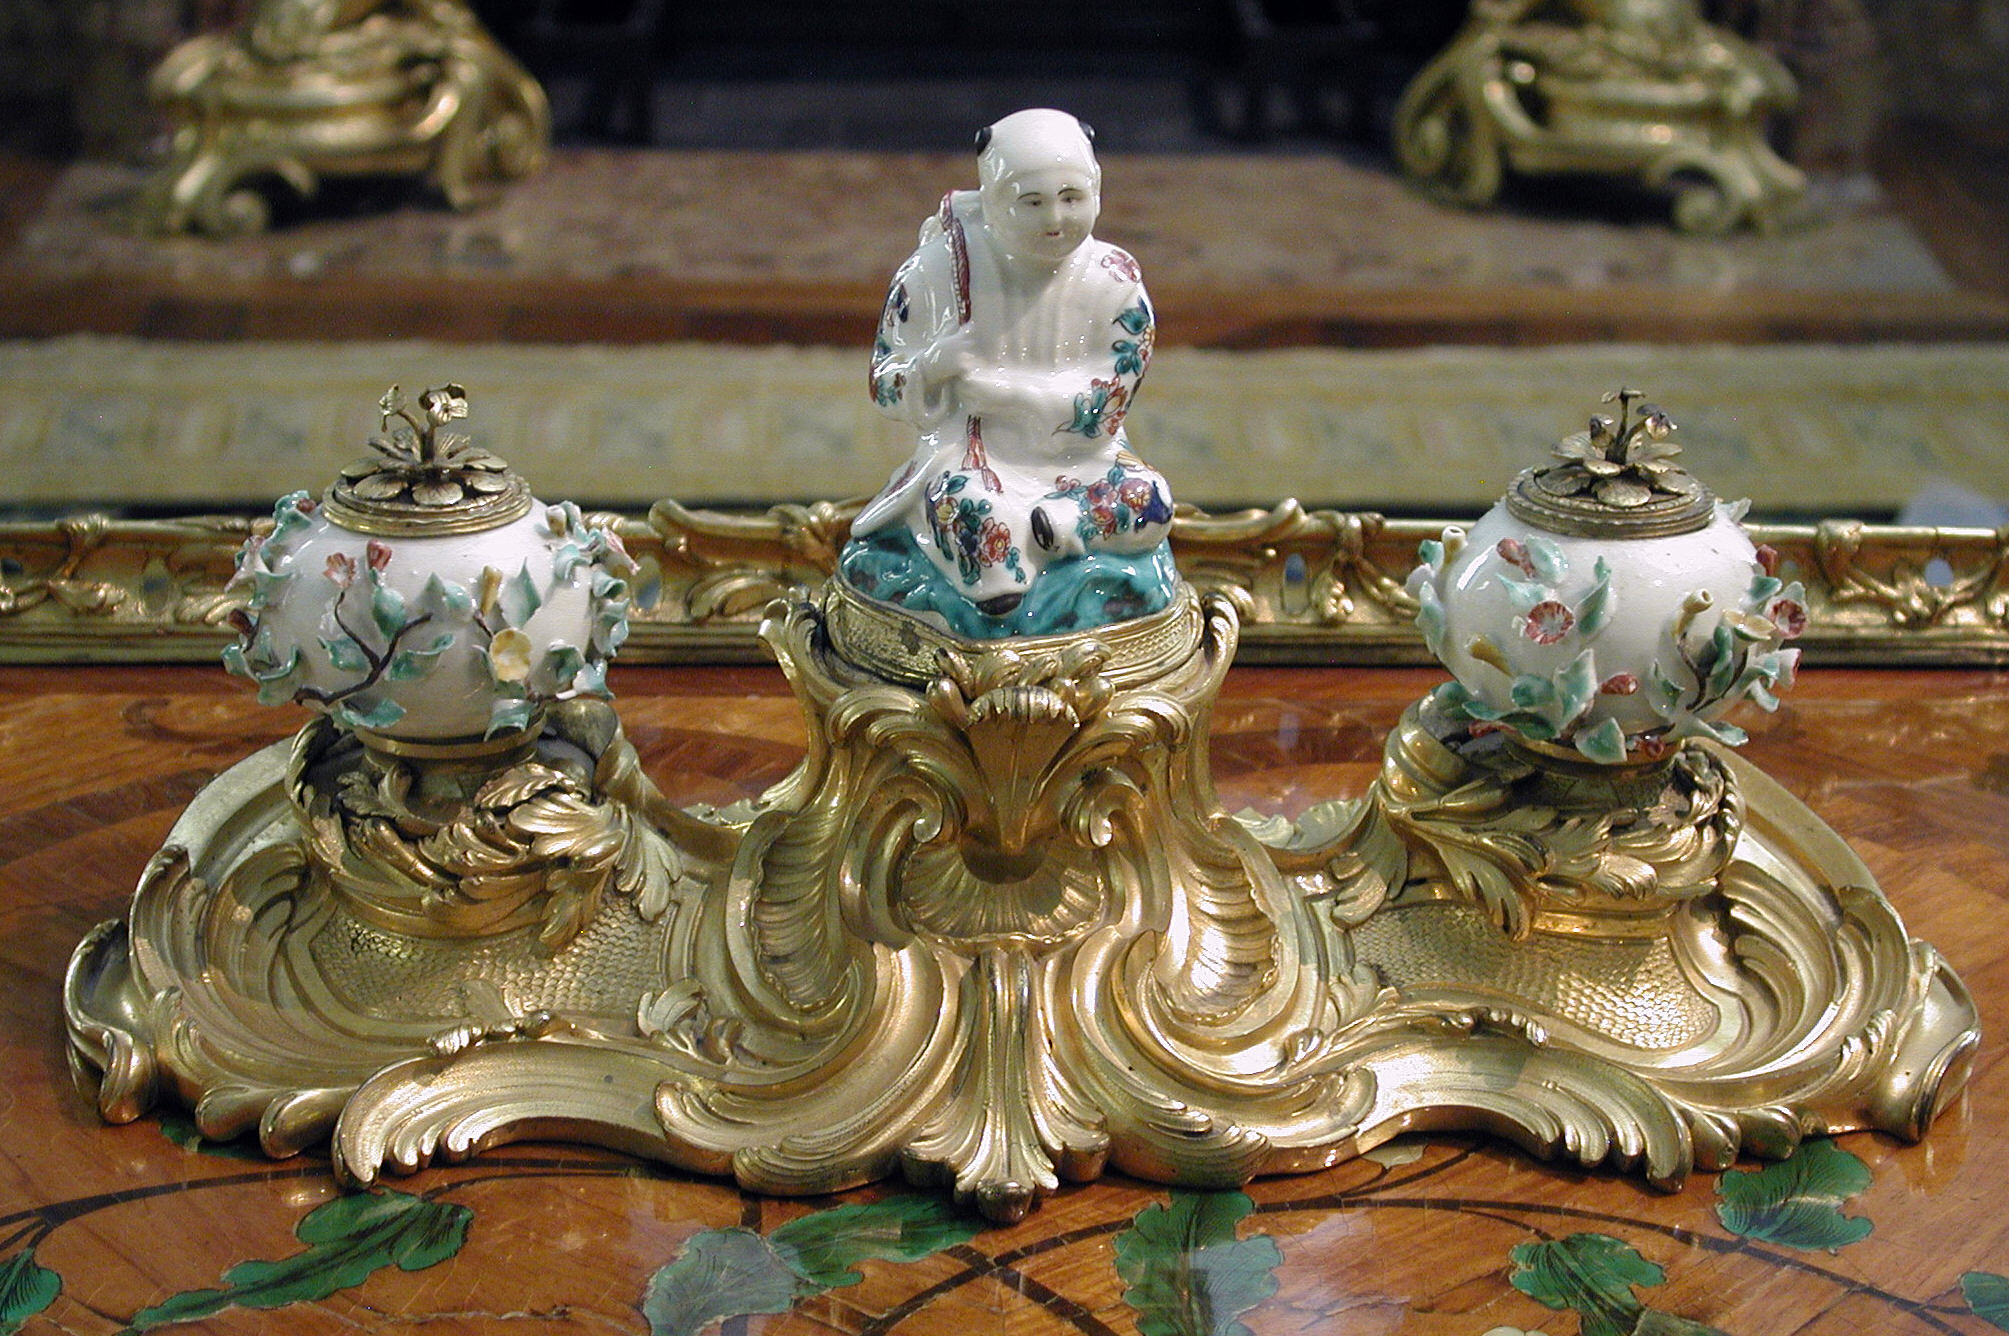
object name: inkstand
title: Inkstand (écritoire)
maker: villeroy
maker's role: factory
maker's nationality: french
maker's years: 1734-1748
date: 1740-1748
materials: gilt bronze, soft paste porcelain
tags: boys